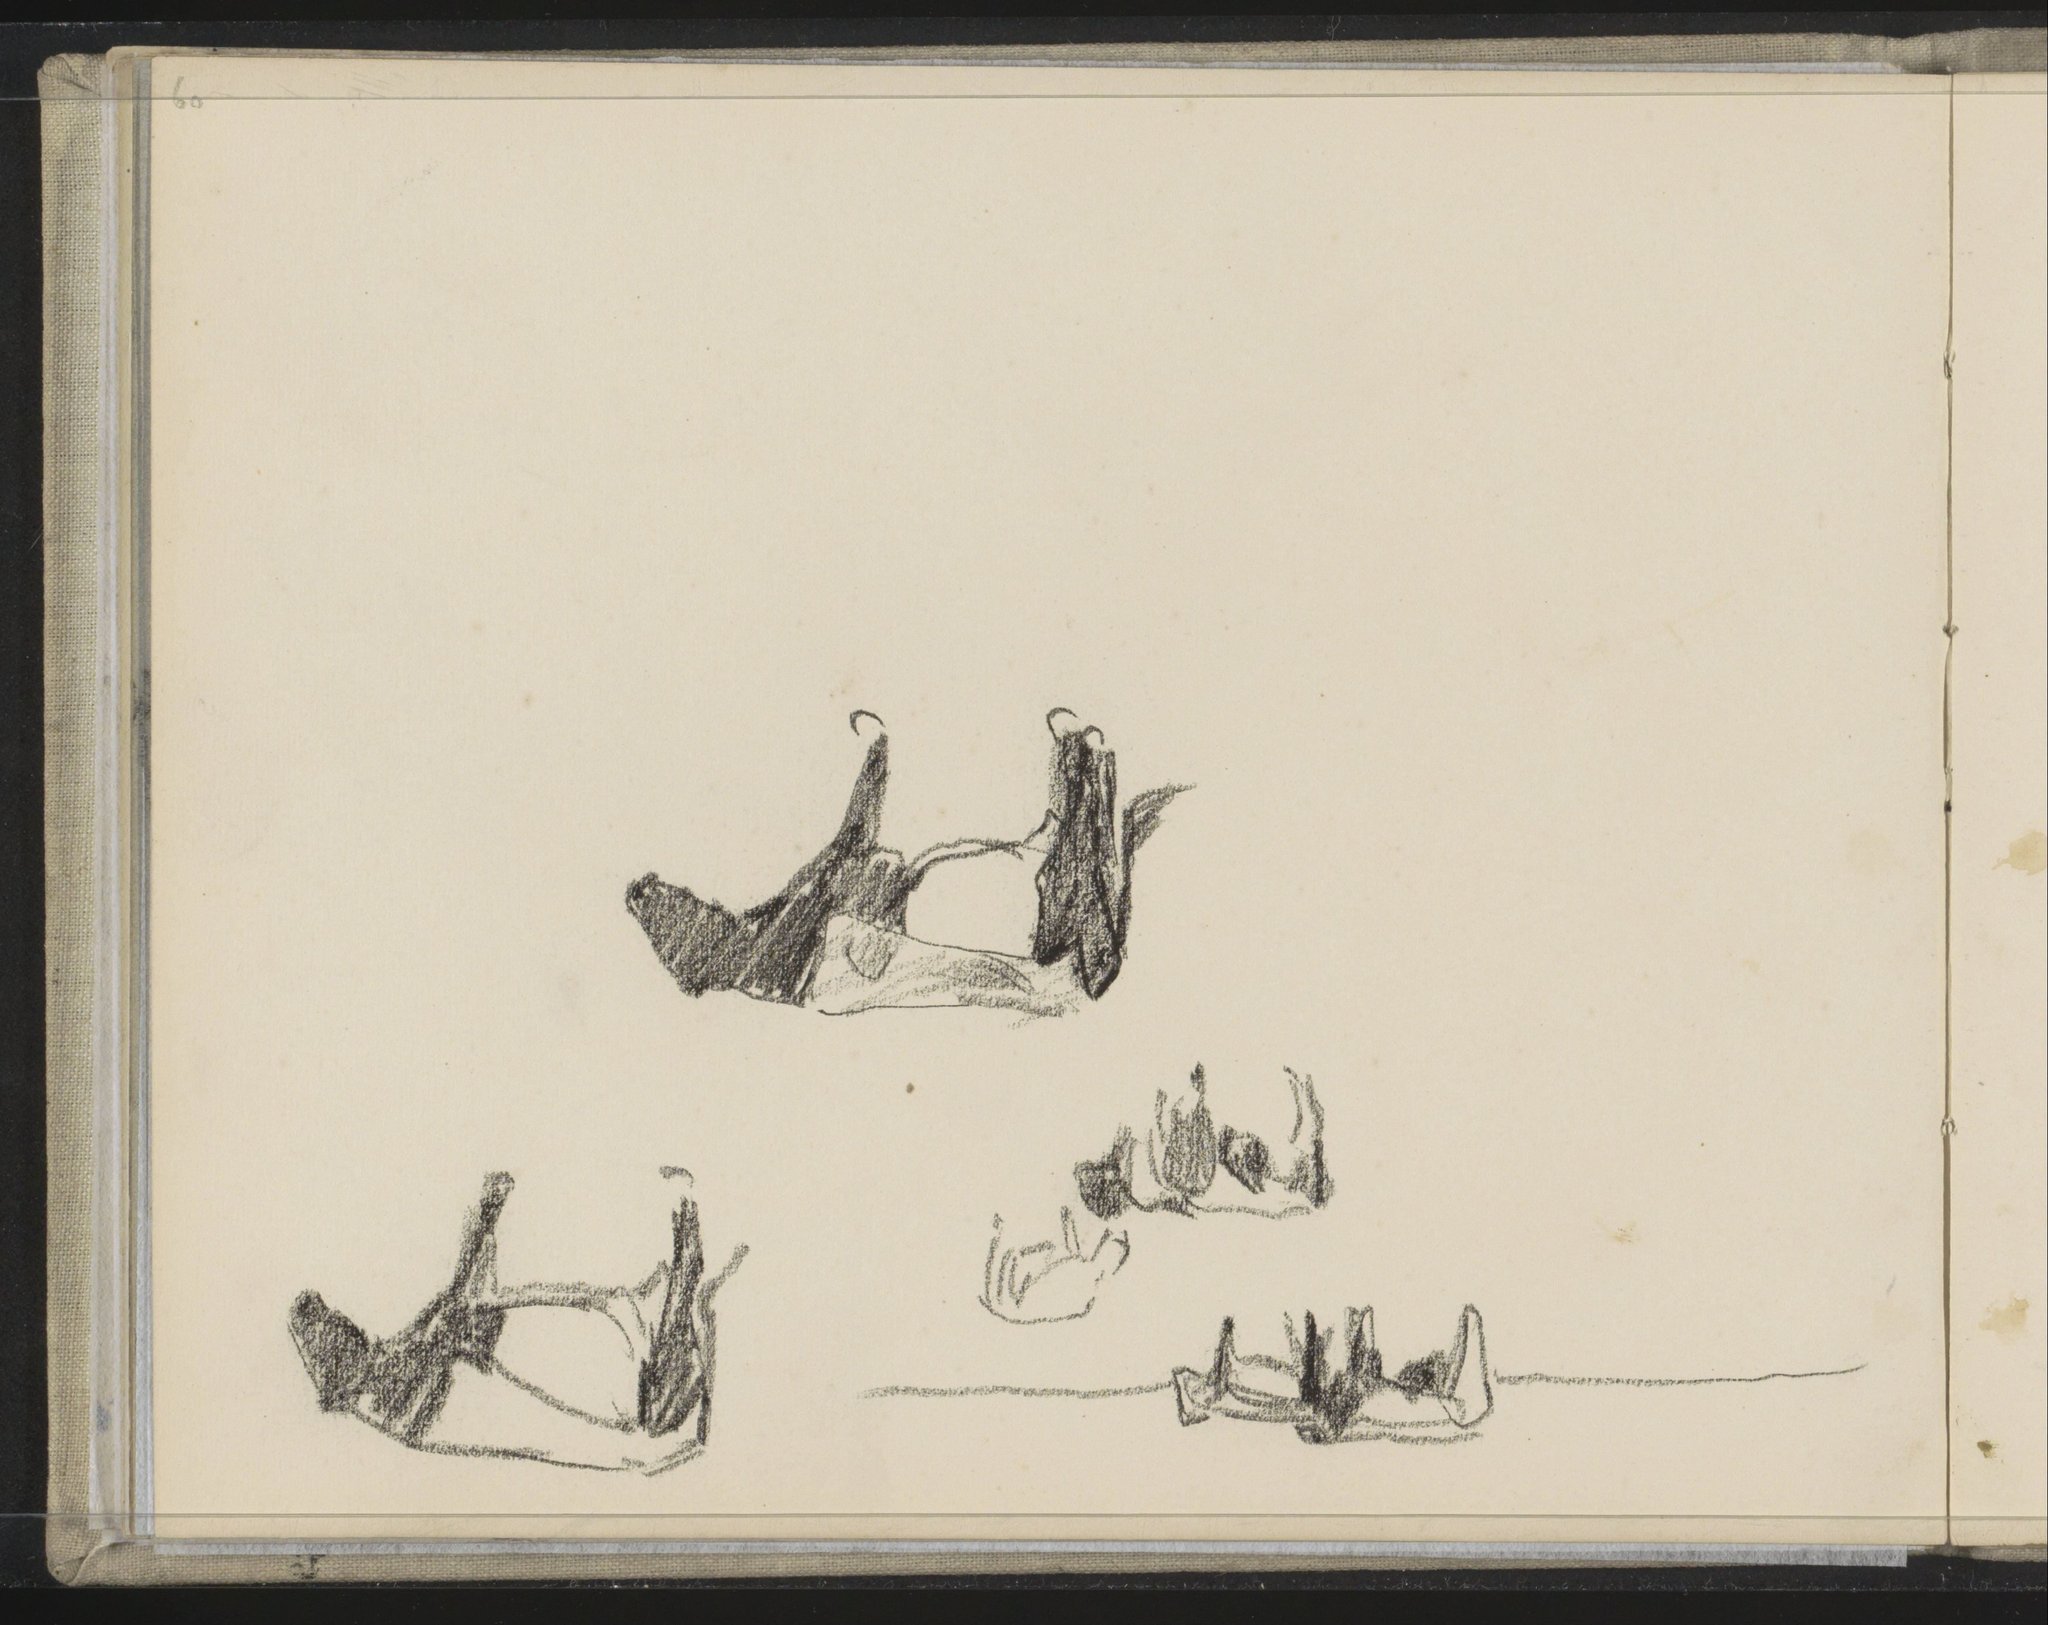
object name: sketchbook leaf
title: Koeien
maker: willem witsen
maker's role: draughtsman, painter, print maker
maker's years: 1860-1923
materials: chalk, paper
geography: wijk bij duurstede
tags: cow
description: Pagina 60 uit een schetsboek met 43 bladen.